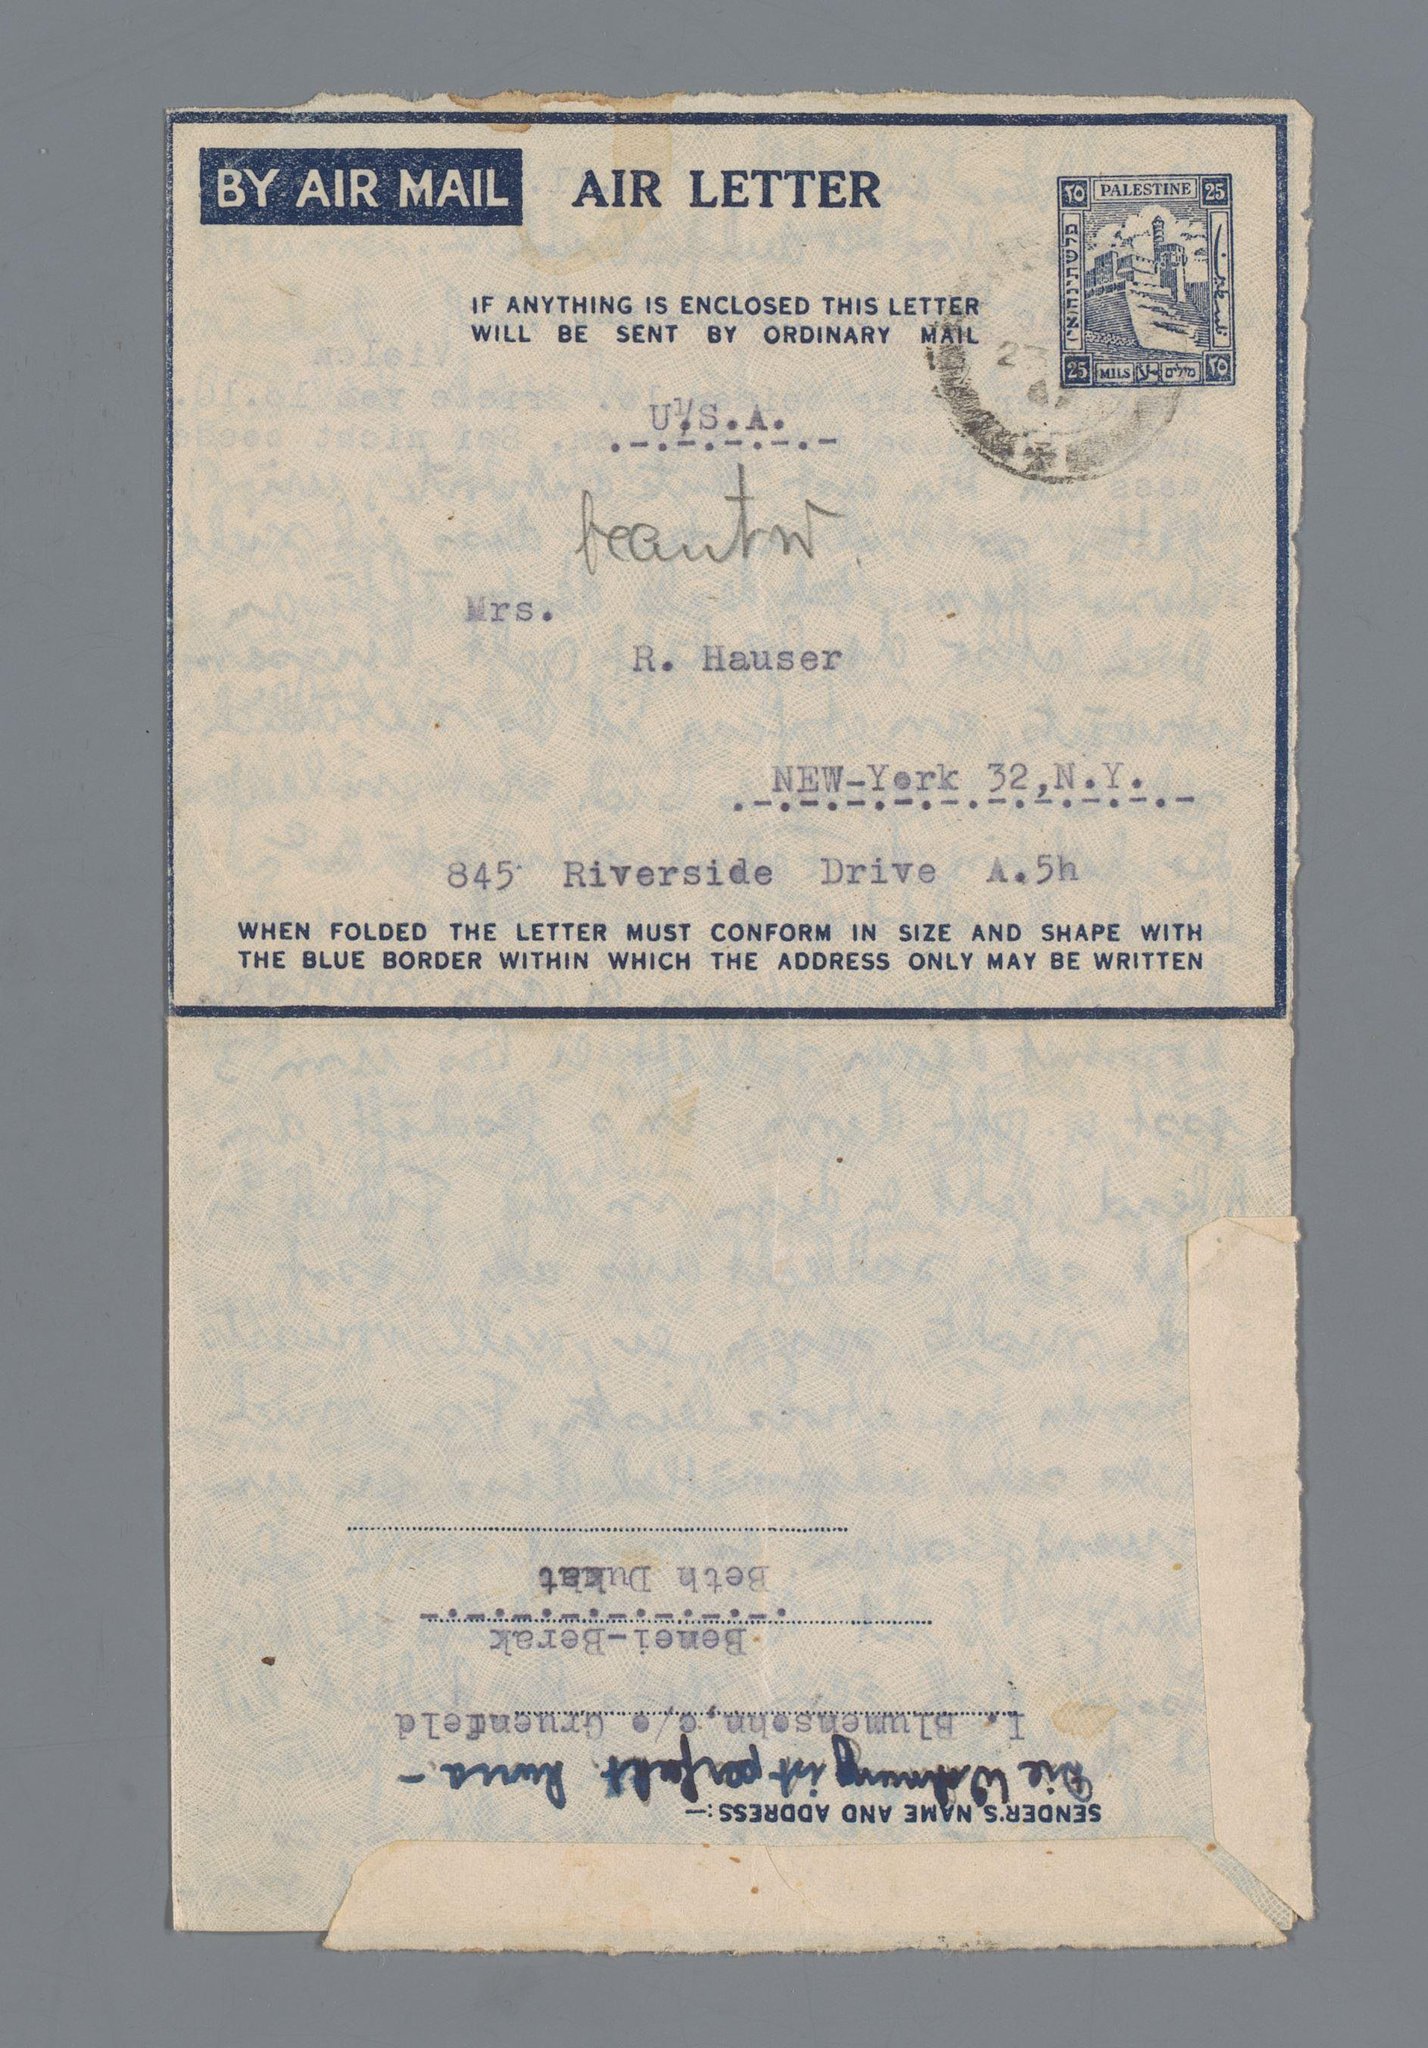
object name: letter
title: Brieven van Isabel aan tante Rosel Hauser, van 1946 tot en met 1949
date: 1945-1949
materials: paper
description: Dit object is onderdeel van de nalatenschap van Isabel Elon-Wachenheimer (1928-2010). Tot haar overlijden behoorde het samen met de andere objecten uit de nalatenschap tot haar privédomein van Isabel Wachenheimer. In die particuliere context zijn deze objecten tezamen en individueel aandenkens - aan de jeugd, ouders en familie van Isabel Wachenheimer vóór en tijdens de Shoah en aan haar leven na de Tweede Wereldoorlog. Isabel Wachenheimer, die van juni 1943 tot mei 1945 gevangen zat in Kamp Westerbork, Theresienstadt, Auschwitz, Lenzing a/d Oberdonau (een buitenkamp van Mauthausen), overleefde de Shoah. Haar ouders – Eugène Wachenheimer en Else Wachenheimer-Moos - werden op 14 oktober 1944 in Auschwitz-Birkenau vermoord.